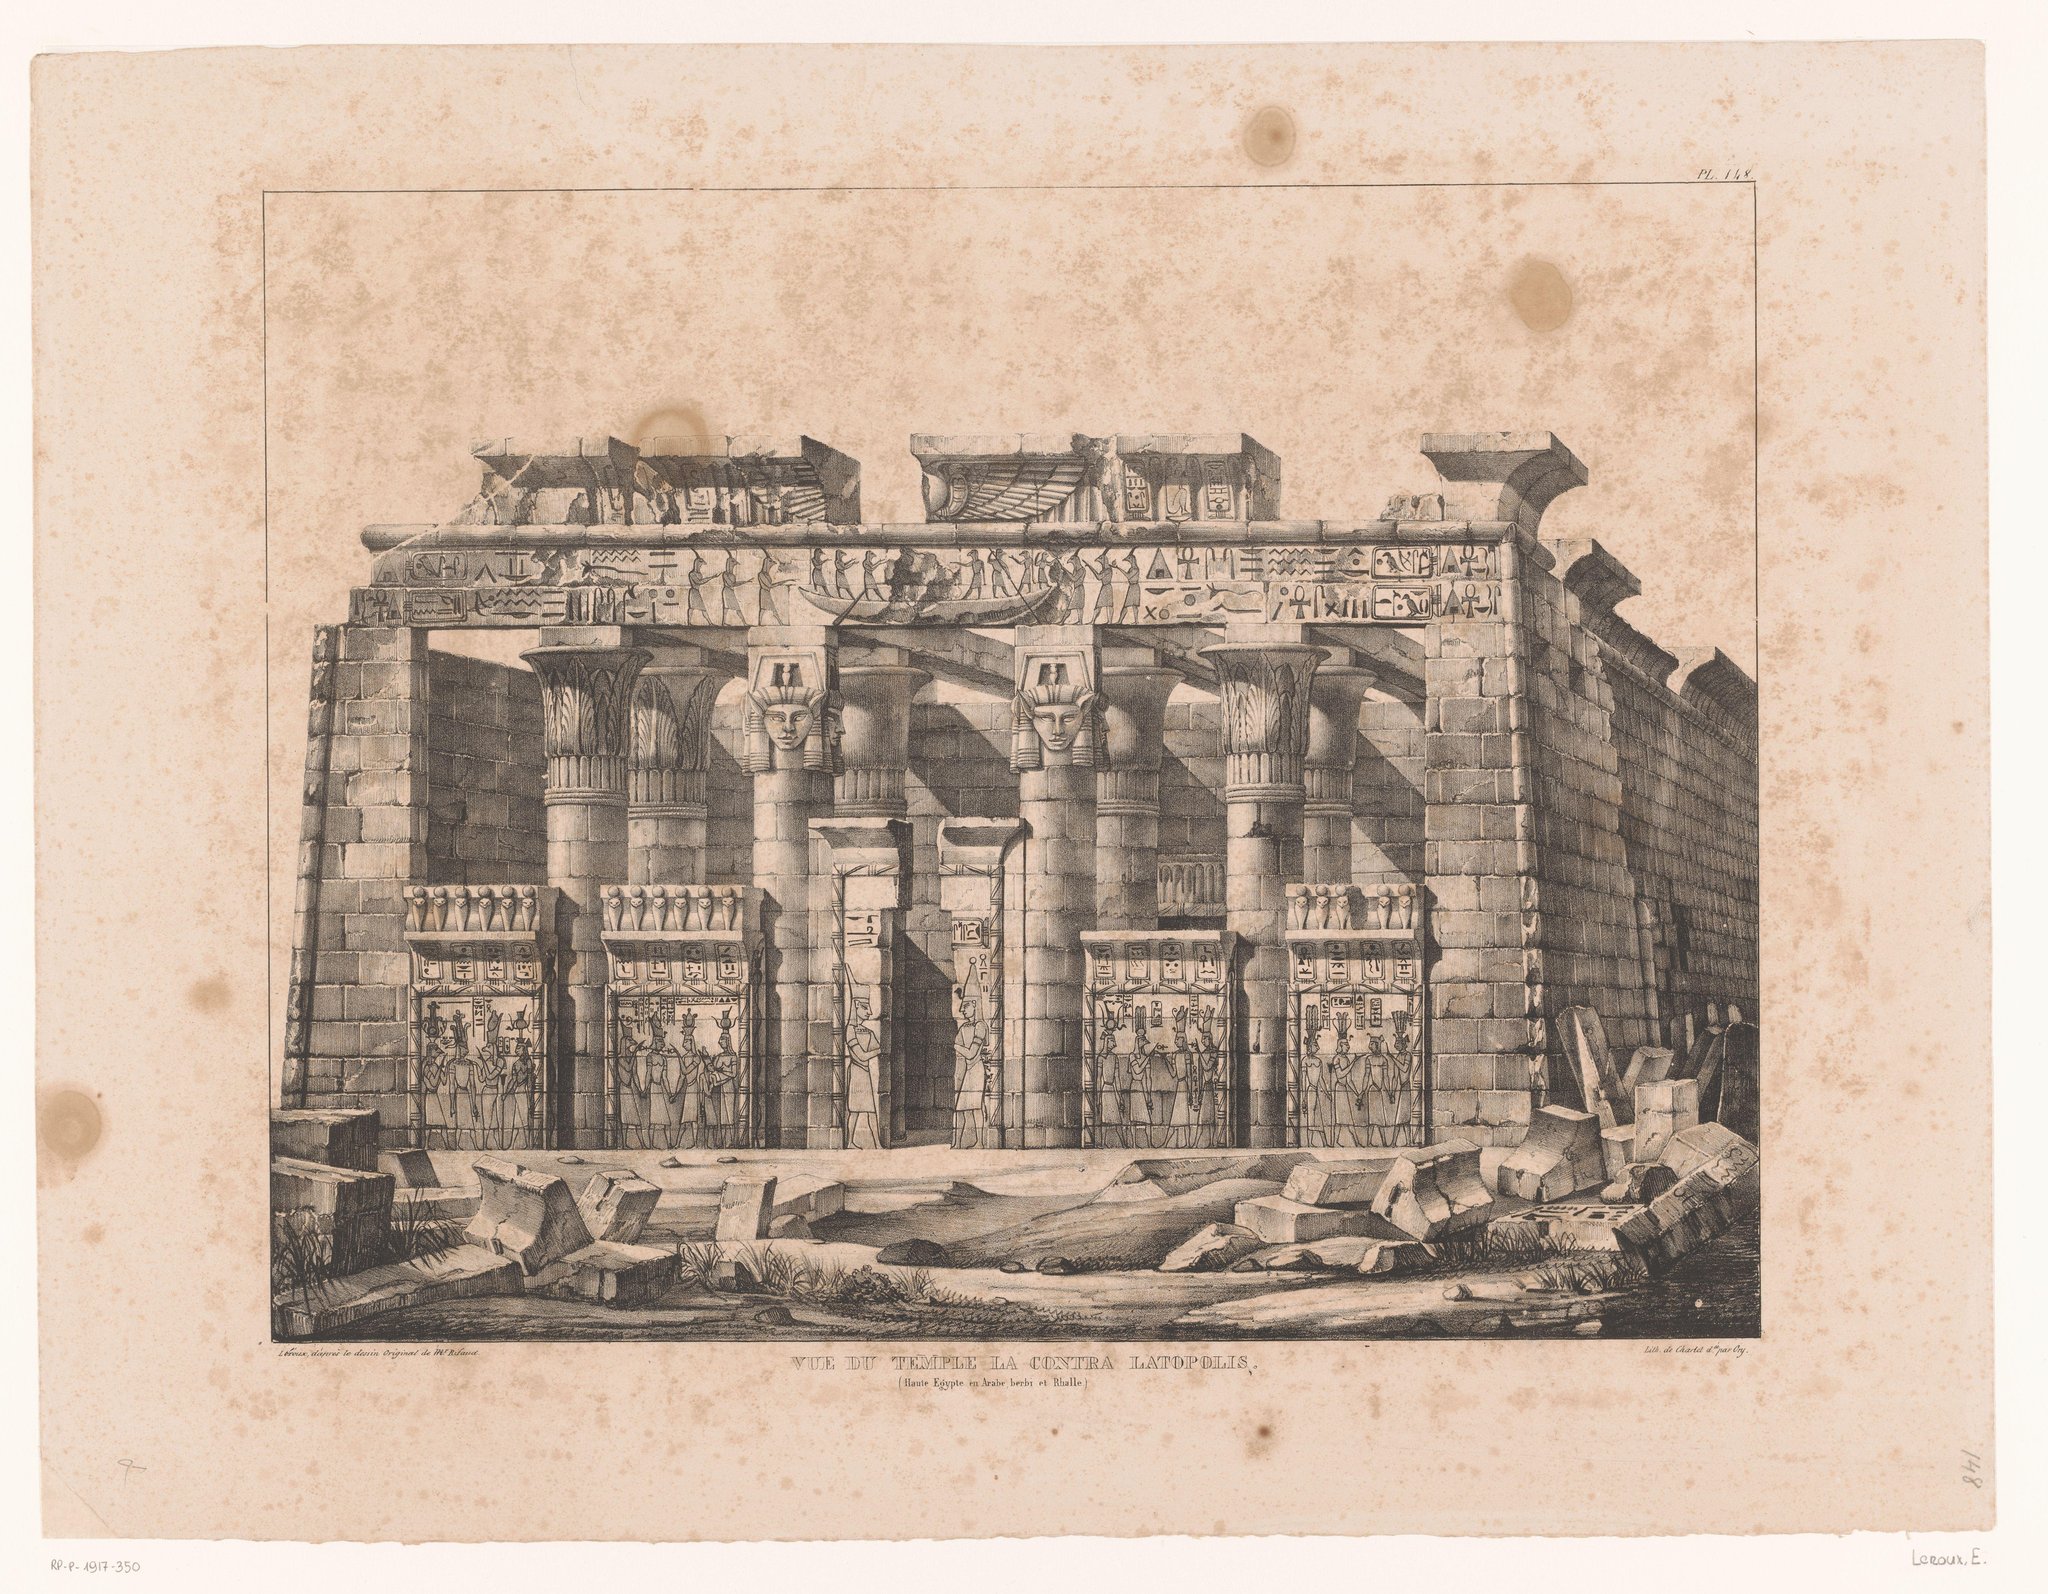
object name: print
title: Gezicht op de Tempel van Esna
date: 1829-1845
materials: paper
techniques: lithograph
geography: paris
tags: temple, shrine ~ egyptian religion, ruin of a building ~ architecture, egyptian hieroglyphs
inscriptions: collector's mark: Lugt 2228, check stamp:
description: Deze prent maakt deel uit van een serie.